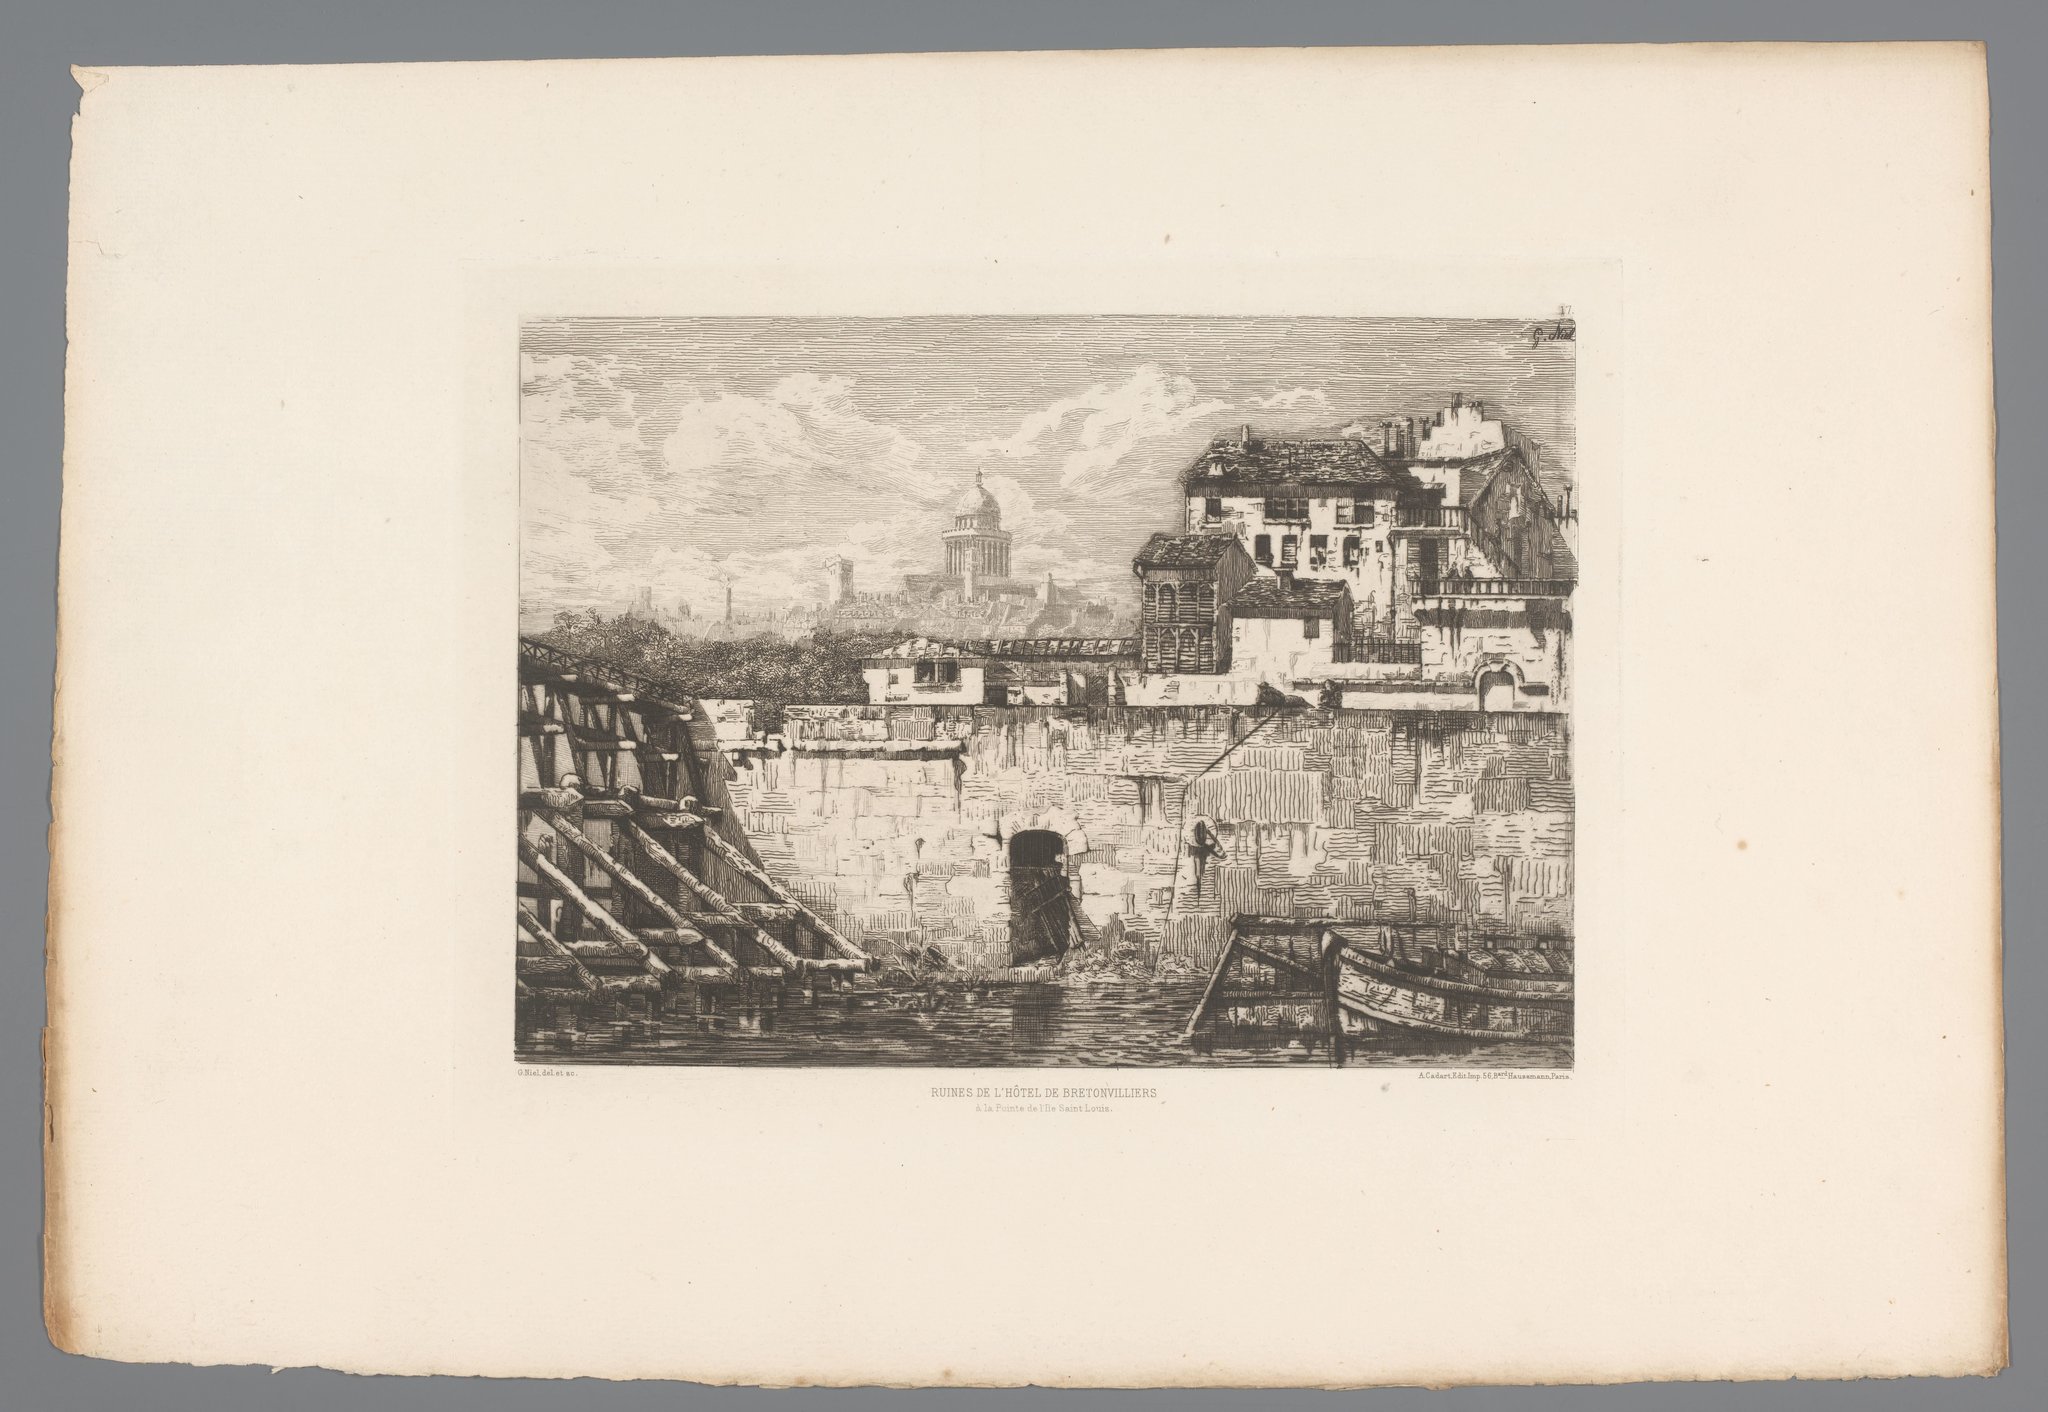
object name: print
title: Ruines de l'Hôtel de Bretonvilliers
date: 1875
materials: paper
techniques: drypoint, etching, intaglio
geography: paris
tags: ruin of a building ~ architecture, landscape with ruins, hôtel, i.e. small palace in city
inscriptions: collector's mark: Lugt 2228, collector's mark: Lugt 2760, collector's mark: ‘AFE v S’